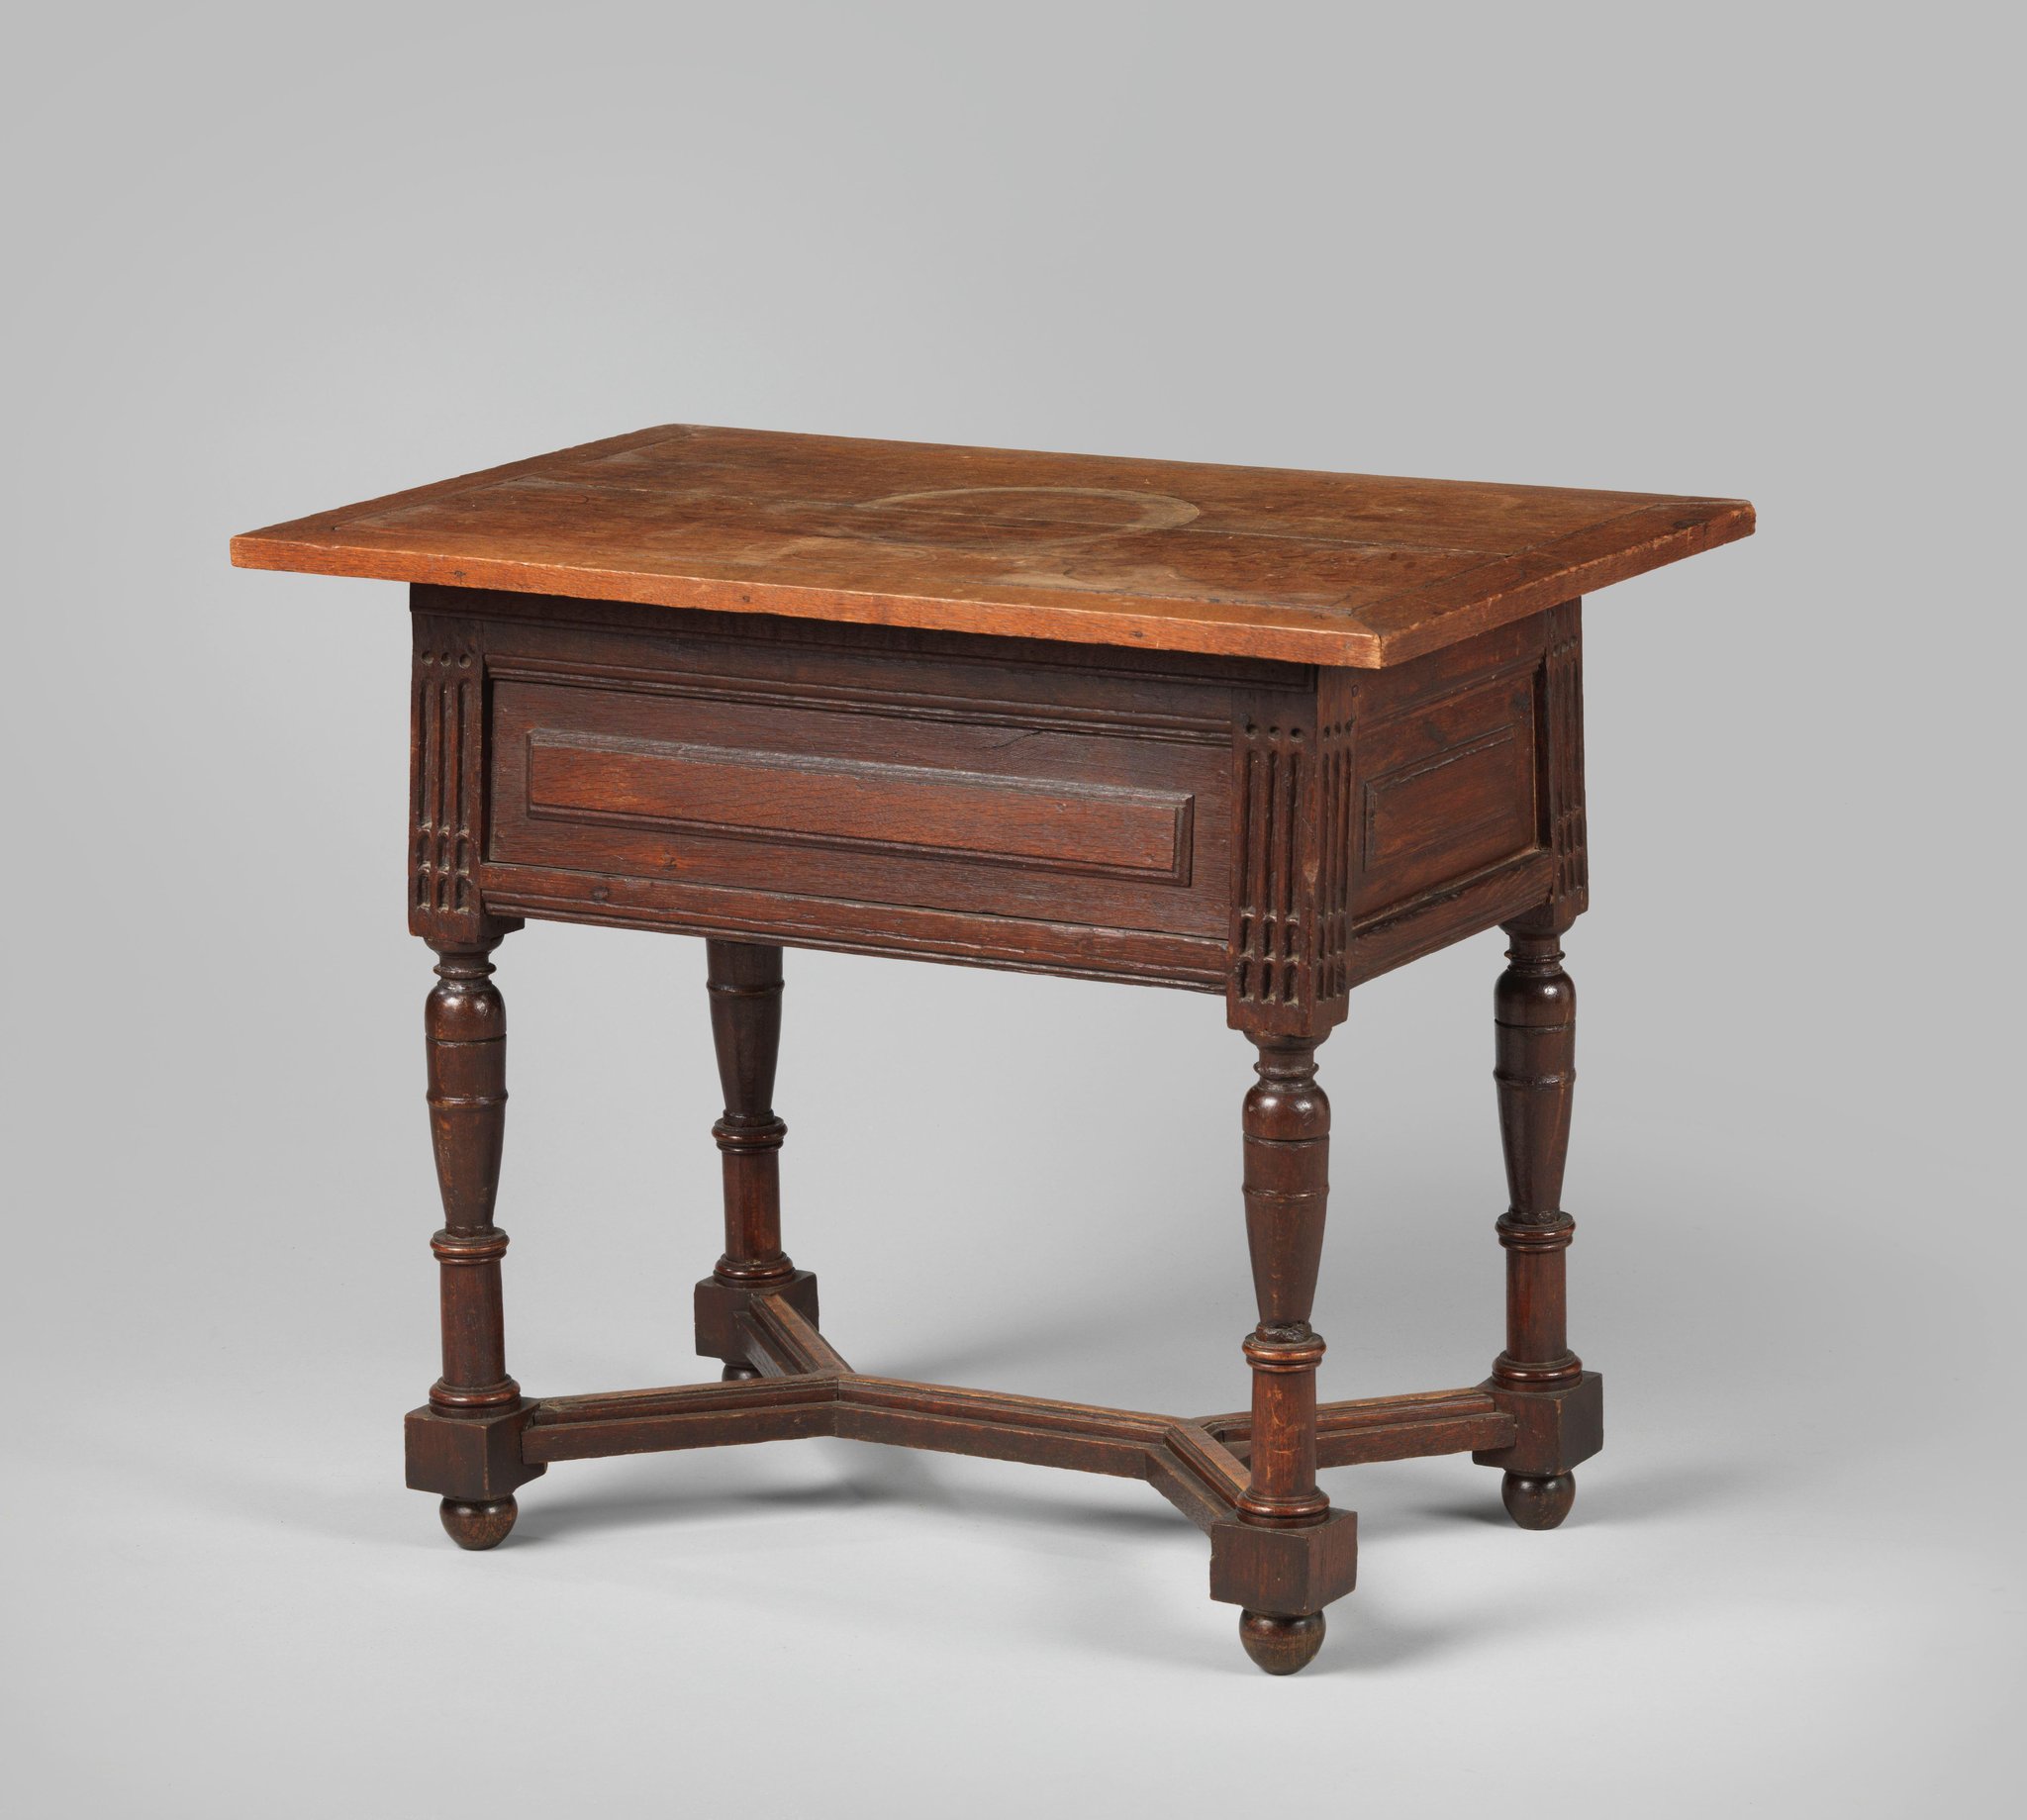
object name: table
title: Meubilair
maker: Anonymous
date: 1600-1699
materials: wood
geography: netherlands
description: Eikenhouten tafel met laag doorgetrokken tafelregel, slanke vaaspoten en een dubbel Y-vormig kruis. De hoekstijlen van het raam zijn gecanneleerd en de panelen in het raam zijn van vlakke kussens voorzien.